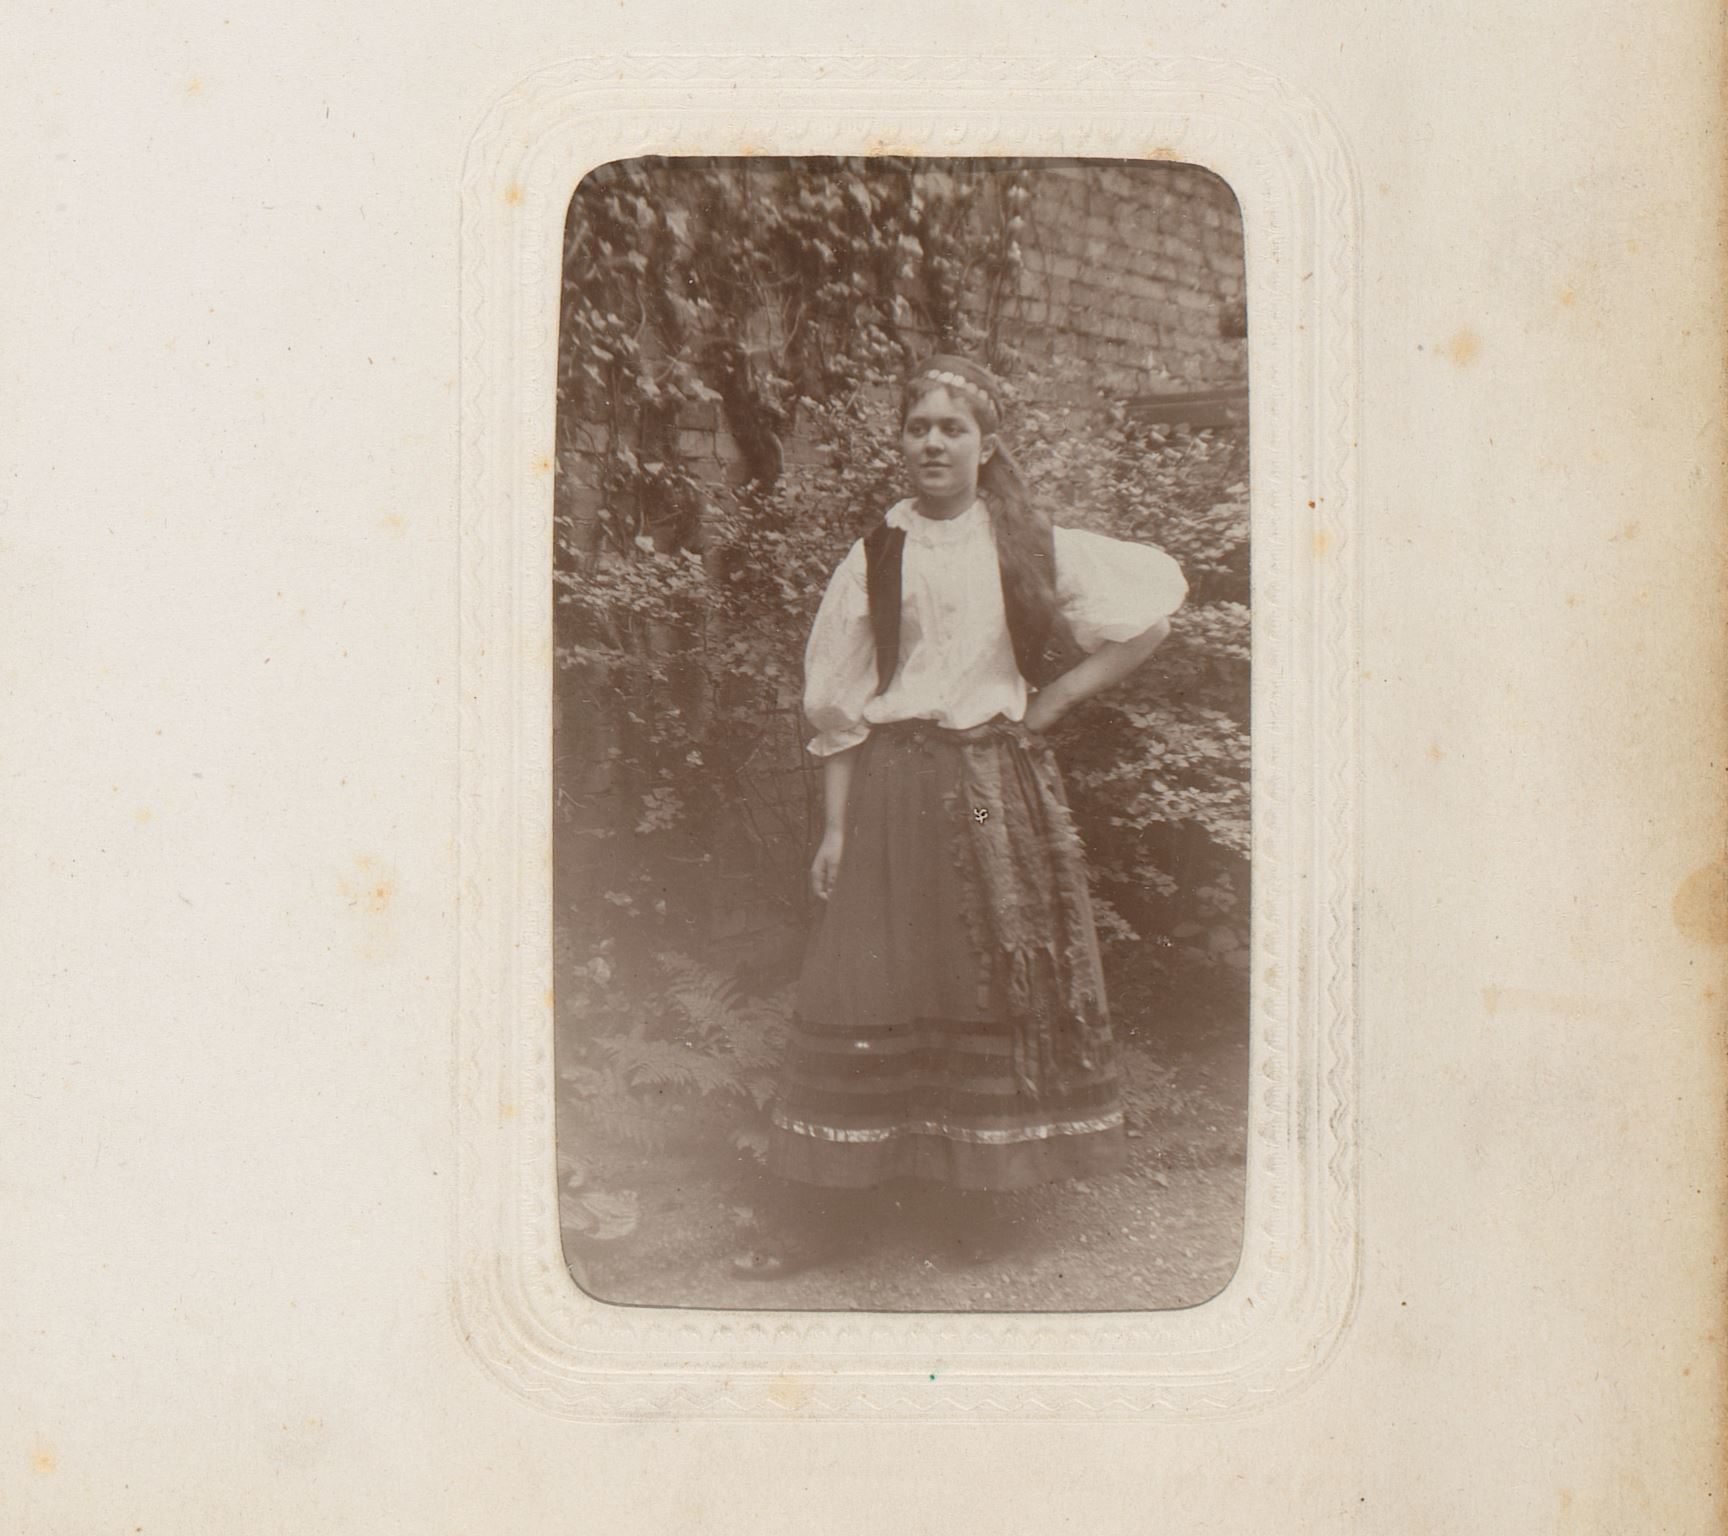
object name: album leaf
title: Portret van een jonge vrouw, staand in een tuin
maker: Anonymous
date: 1880-1920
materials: cardboard, photographic support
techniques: collodion silver print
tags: adolescent, young woman, maiden, historical persons - bb - woman, garden